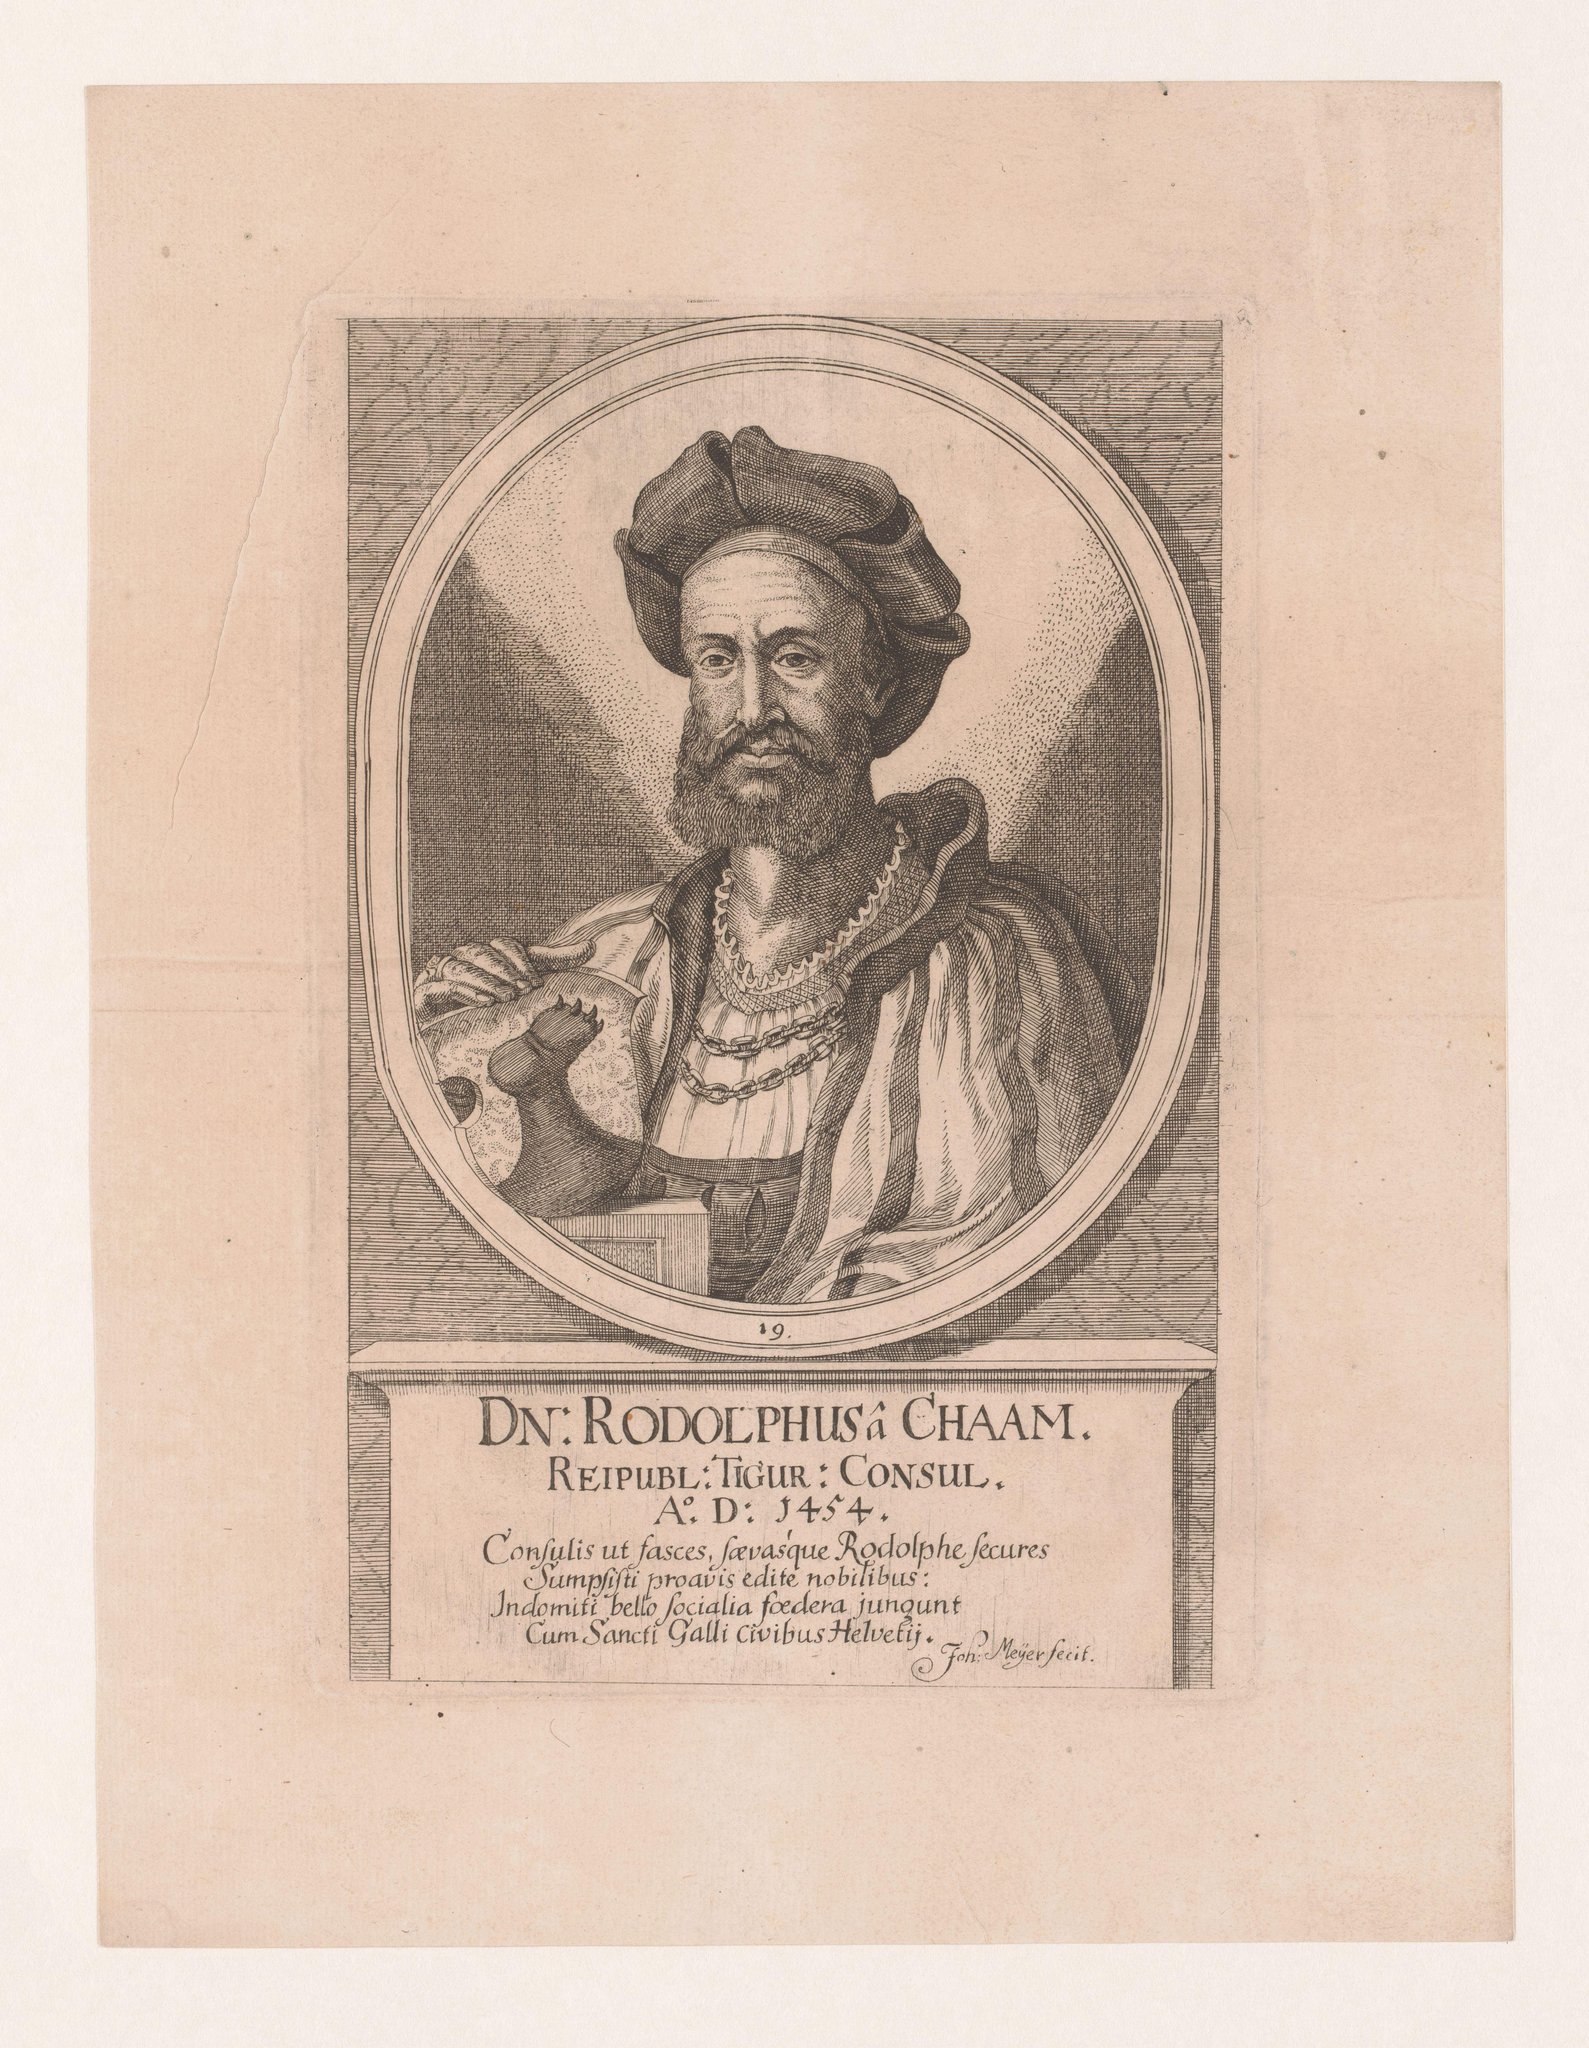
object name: print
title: Portret van Rudolf von Cham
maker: johannes meyer (ii)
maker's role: print maker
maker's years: 1655-1712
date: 1665-1712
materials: paper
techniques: engraving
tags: mayor, burgomaster, other non-personal regalia, e.g. mayor chain, historical persons, armorial bearing, heraldry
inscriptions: collector's mark: Lugt 2228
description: Onderaan de ovale omlijsting genummerd: 19.